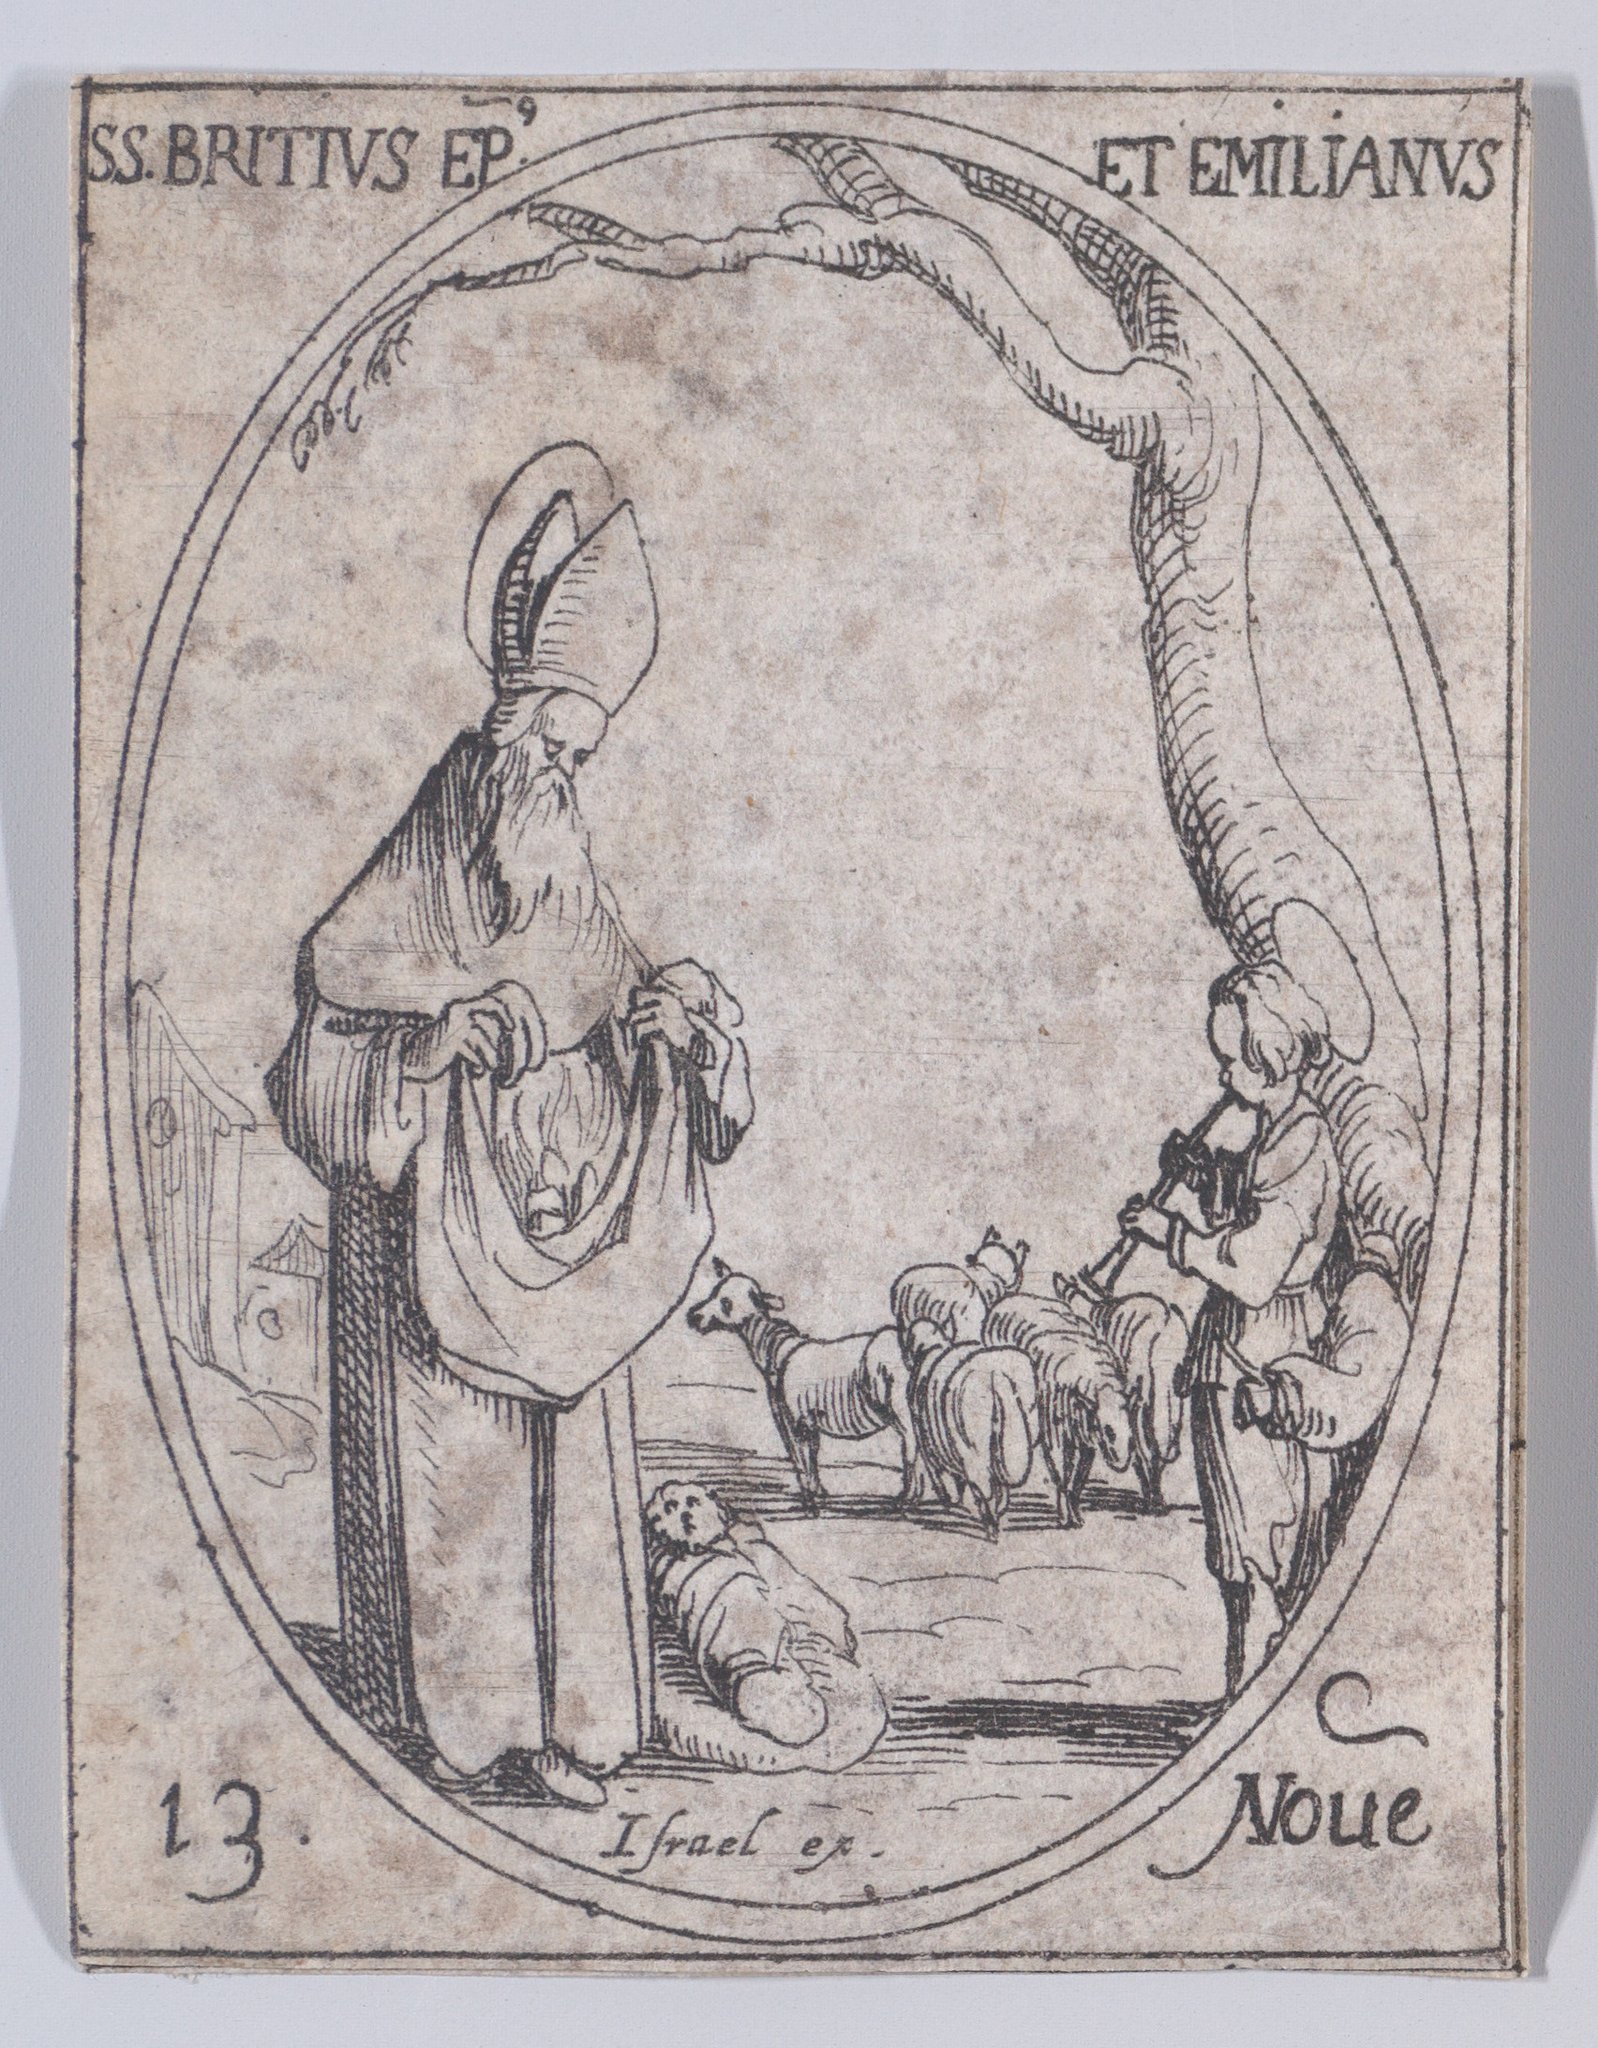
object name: print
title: S. Brice, évêque et S. Emilianus (St. Brice, Bishop and St. Emilianus), November 13th, from "Les Images De Tous Les Saincts et Saintes de L'Année" (Images of All of the Saints and Religious Events of the Year)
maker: jacques callot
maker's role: artist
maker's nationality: french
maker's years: 1592-1635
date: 1636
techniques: etching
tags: infants,men,saints